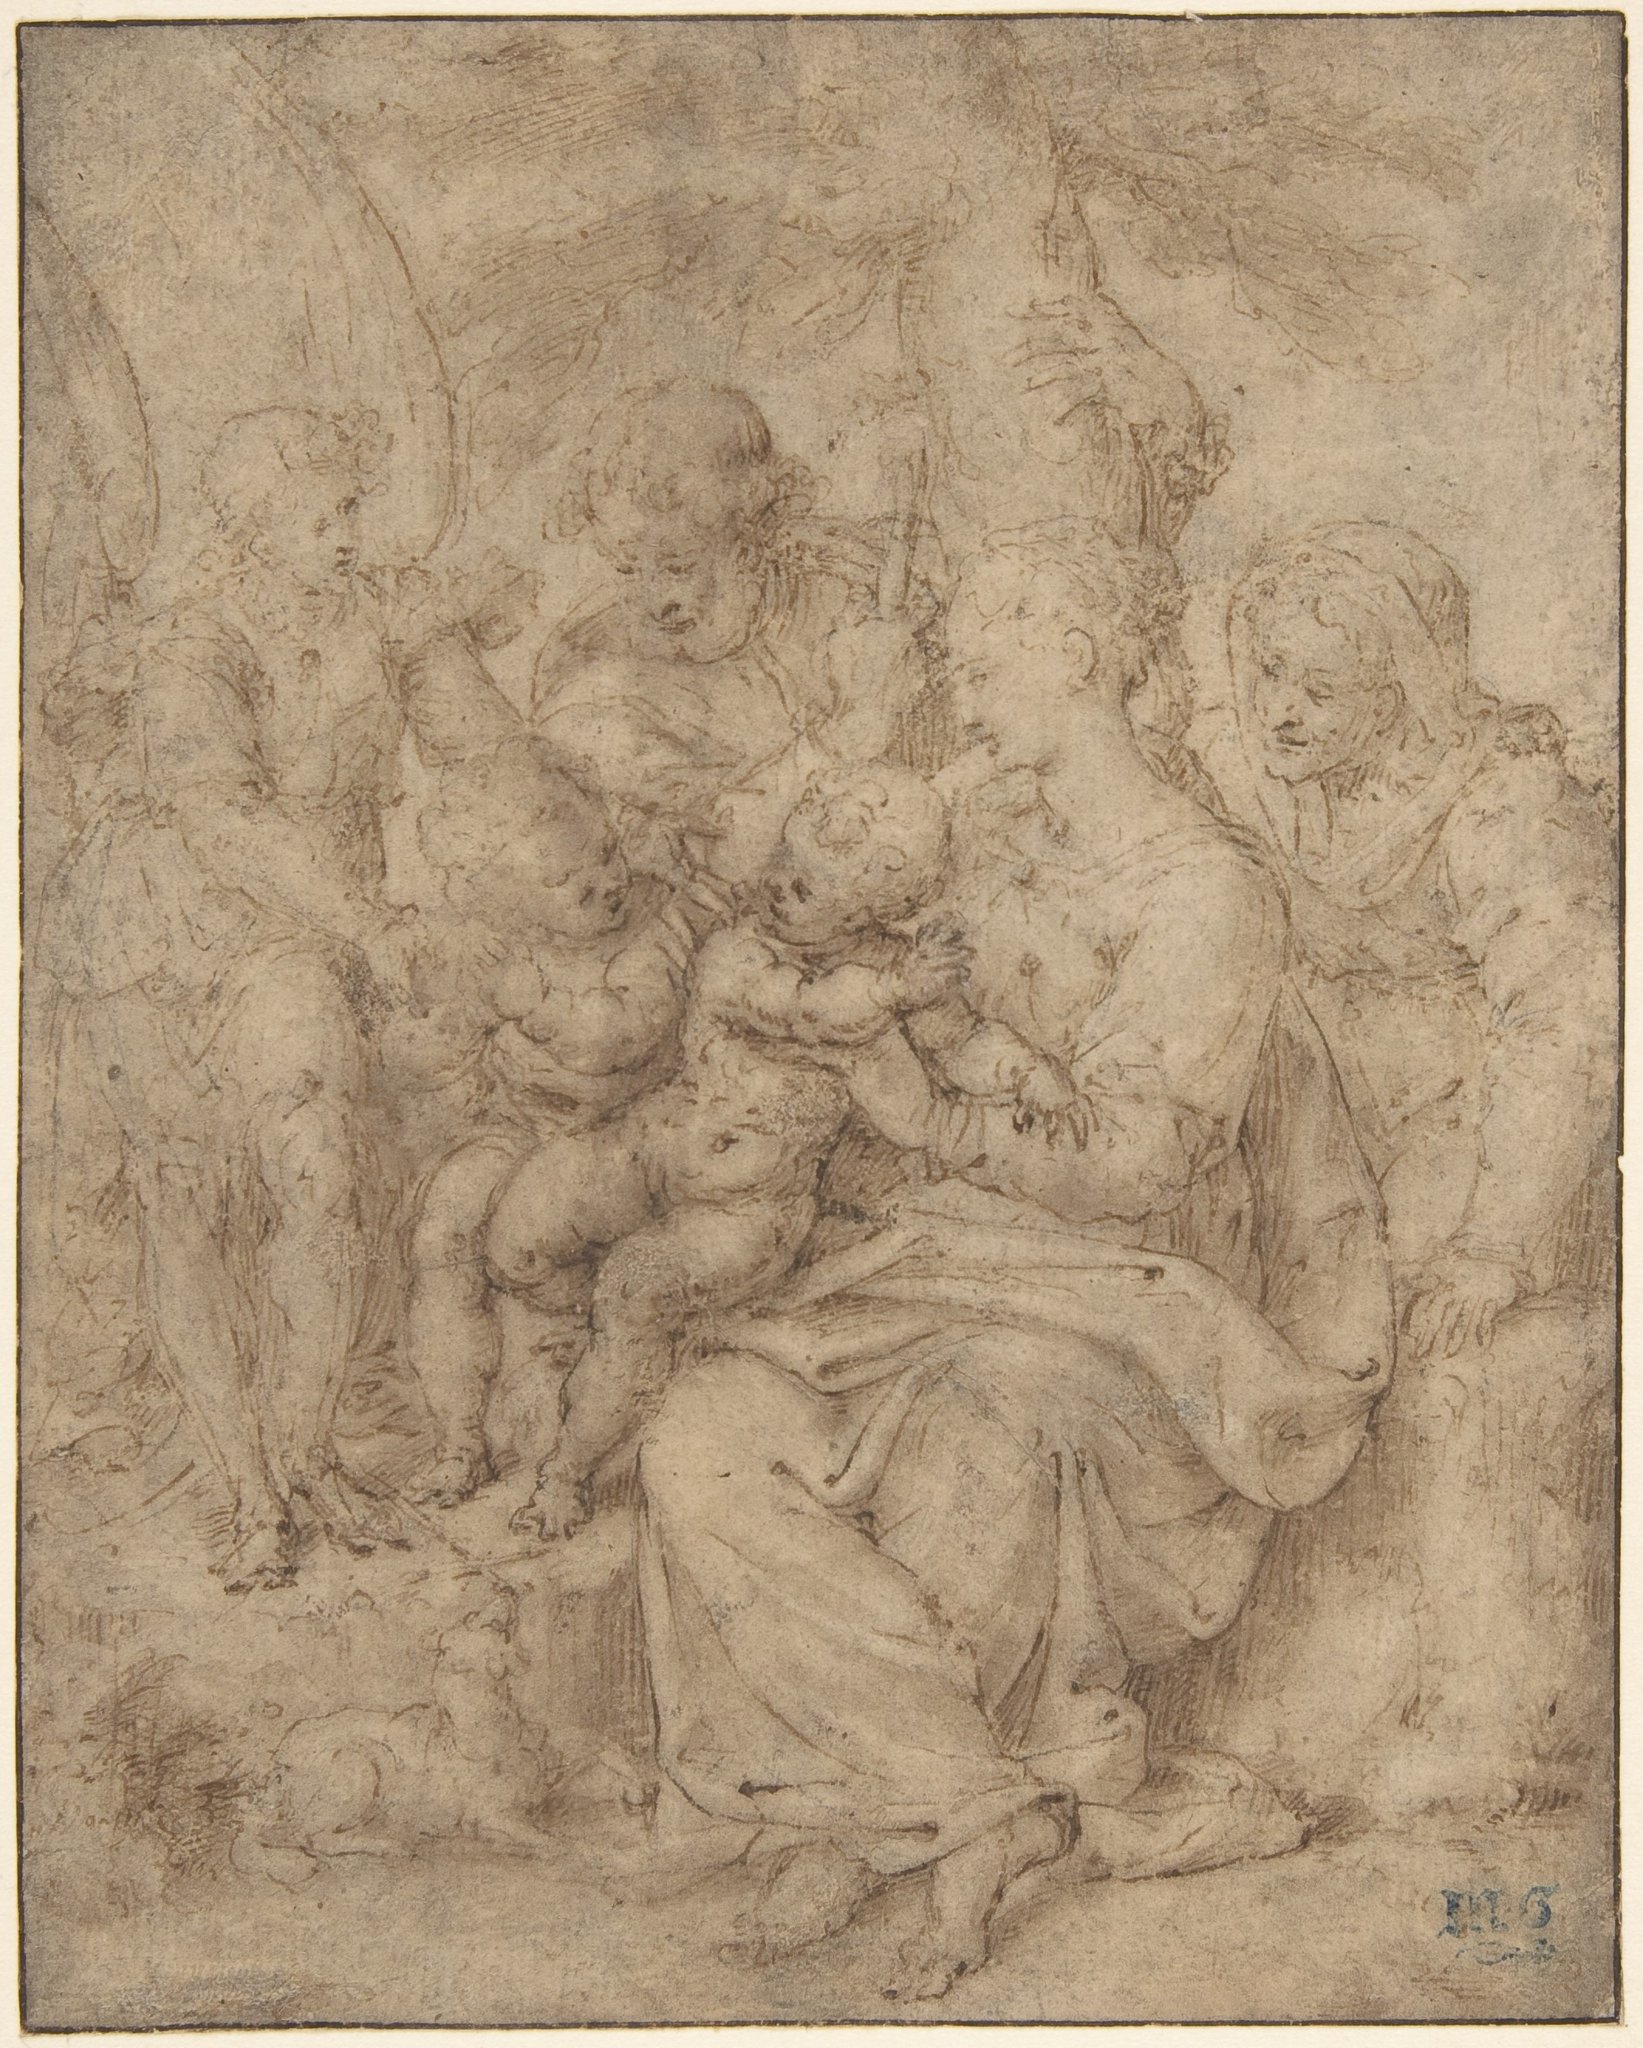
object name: drawing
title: The Holy Family with the Infant Baptist, Saint Elizabeth, and an Attendant Angel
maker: aurelio luini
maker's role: artist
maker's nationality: italian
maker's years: 1530-1593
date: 1550-1560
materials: ink, paper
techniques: brush, pen, wash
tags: angels,holy family,madonna and child,saint john the baptist,saints